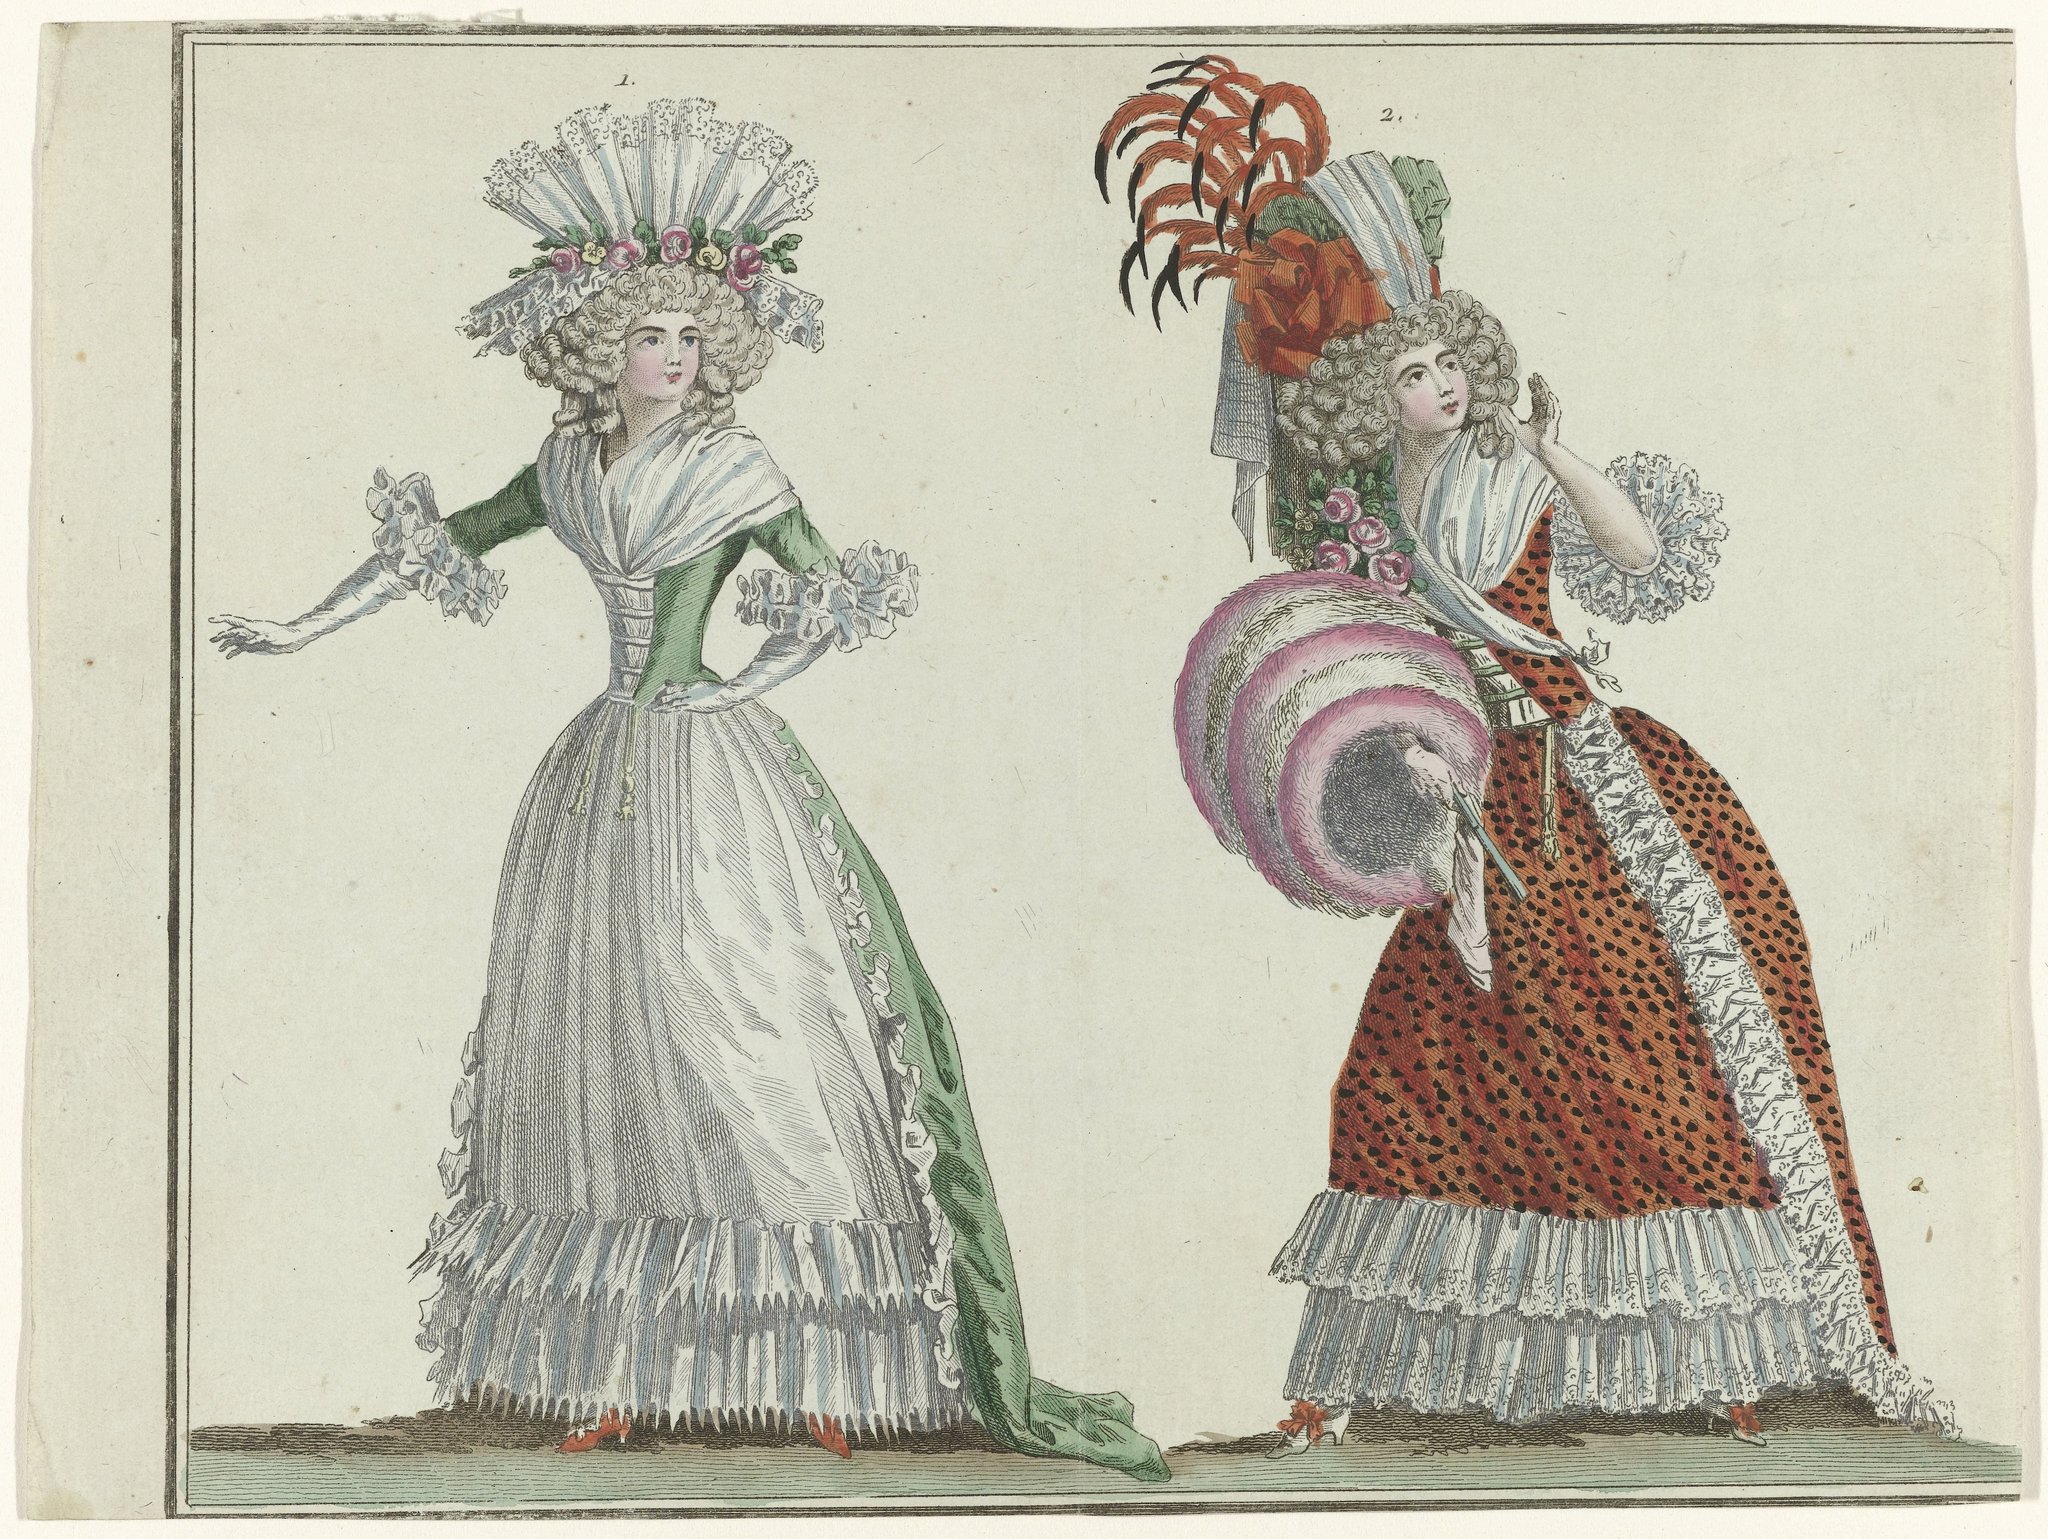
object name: fashion print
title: Fashion News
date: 1788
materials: paper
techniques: engraving, hand coloring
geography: paris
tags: gloves, mittens (long gloves) (+ women's clothes), head-gear: cap (+ women's clothes), fashion plates, skirt (+ women's clothes), dress, gown (+ women's clothes), muff (+ fur used for clothes), piece of clothing covering the breast or décolleté (fichu) (+ women's clothes), sleeves (+ women's clothes), muff (+ women's clothes)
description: The Cabinet des Modes offered readers highly detailed information about the illustrated clothes and accessories. It reported, for instance, on new clothing styles, such as the English ‘redingote’ 1; on accessories and embellishments, such as oversized muffs, buttons, ribbons and clasps; and finally, on the latest interior furnishings. For its male audience there was the fitted jacket 2 and the popular Androsmane, a hat with an upturned brim 3.